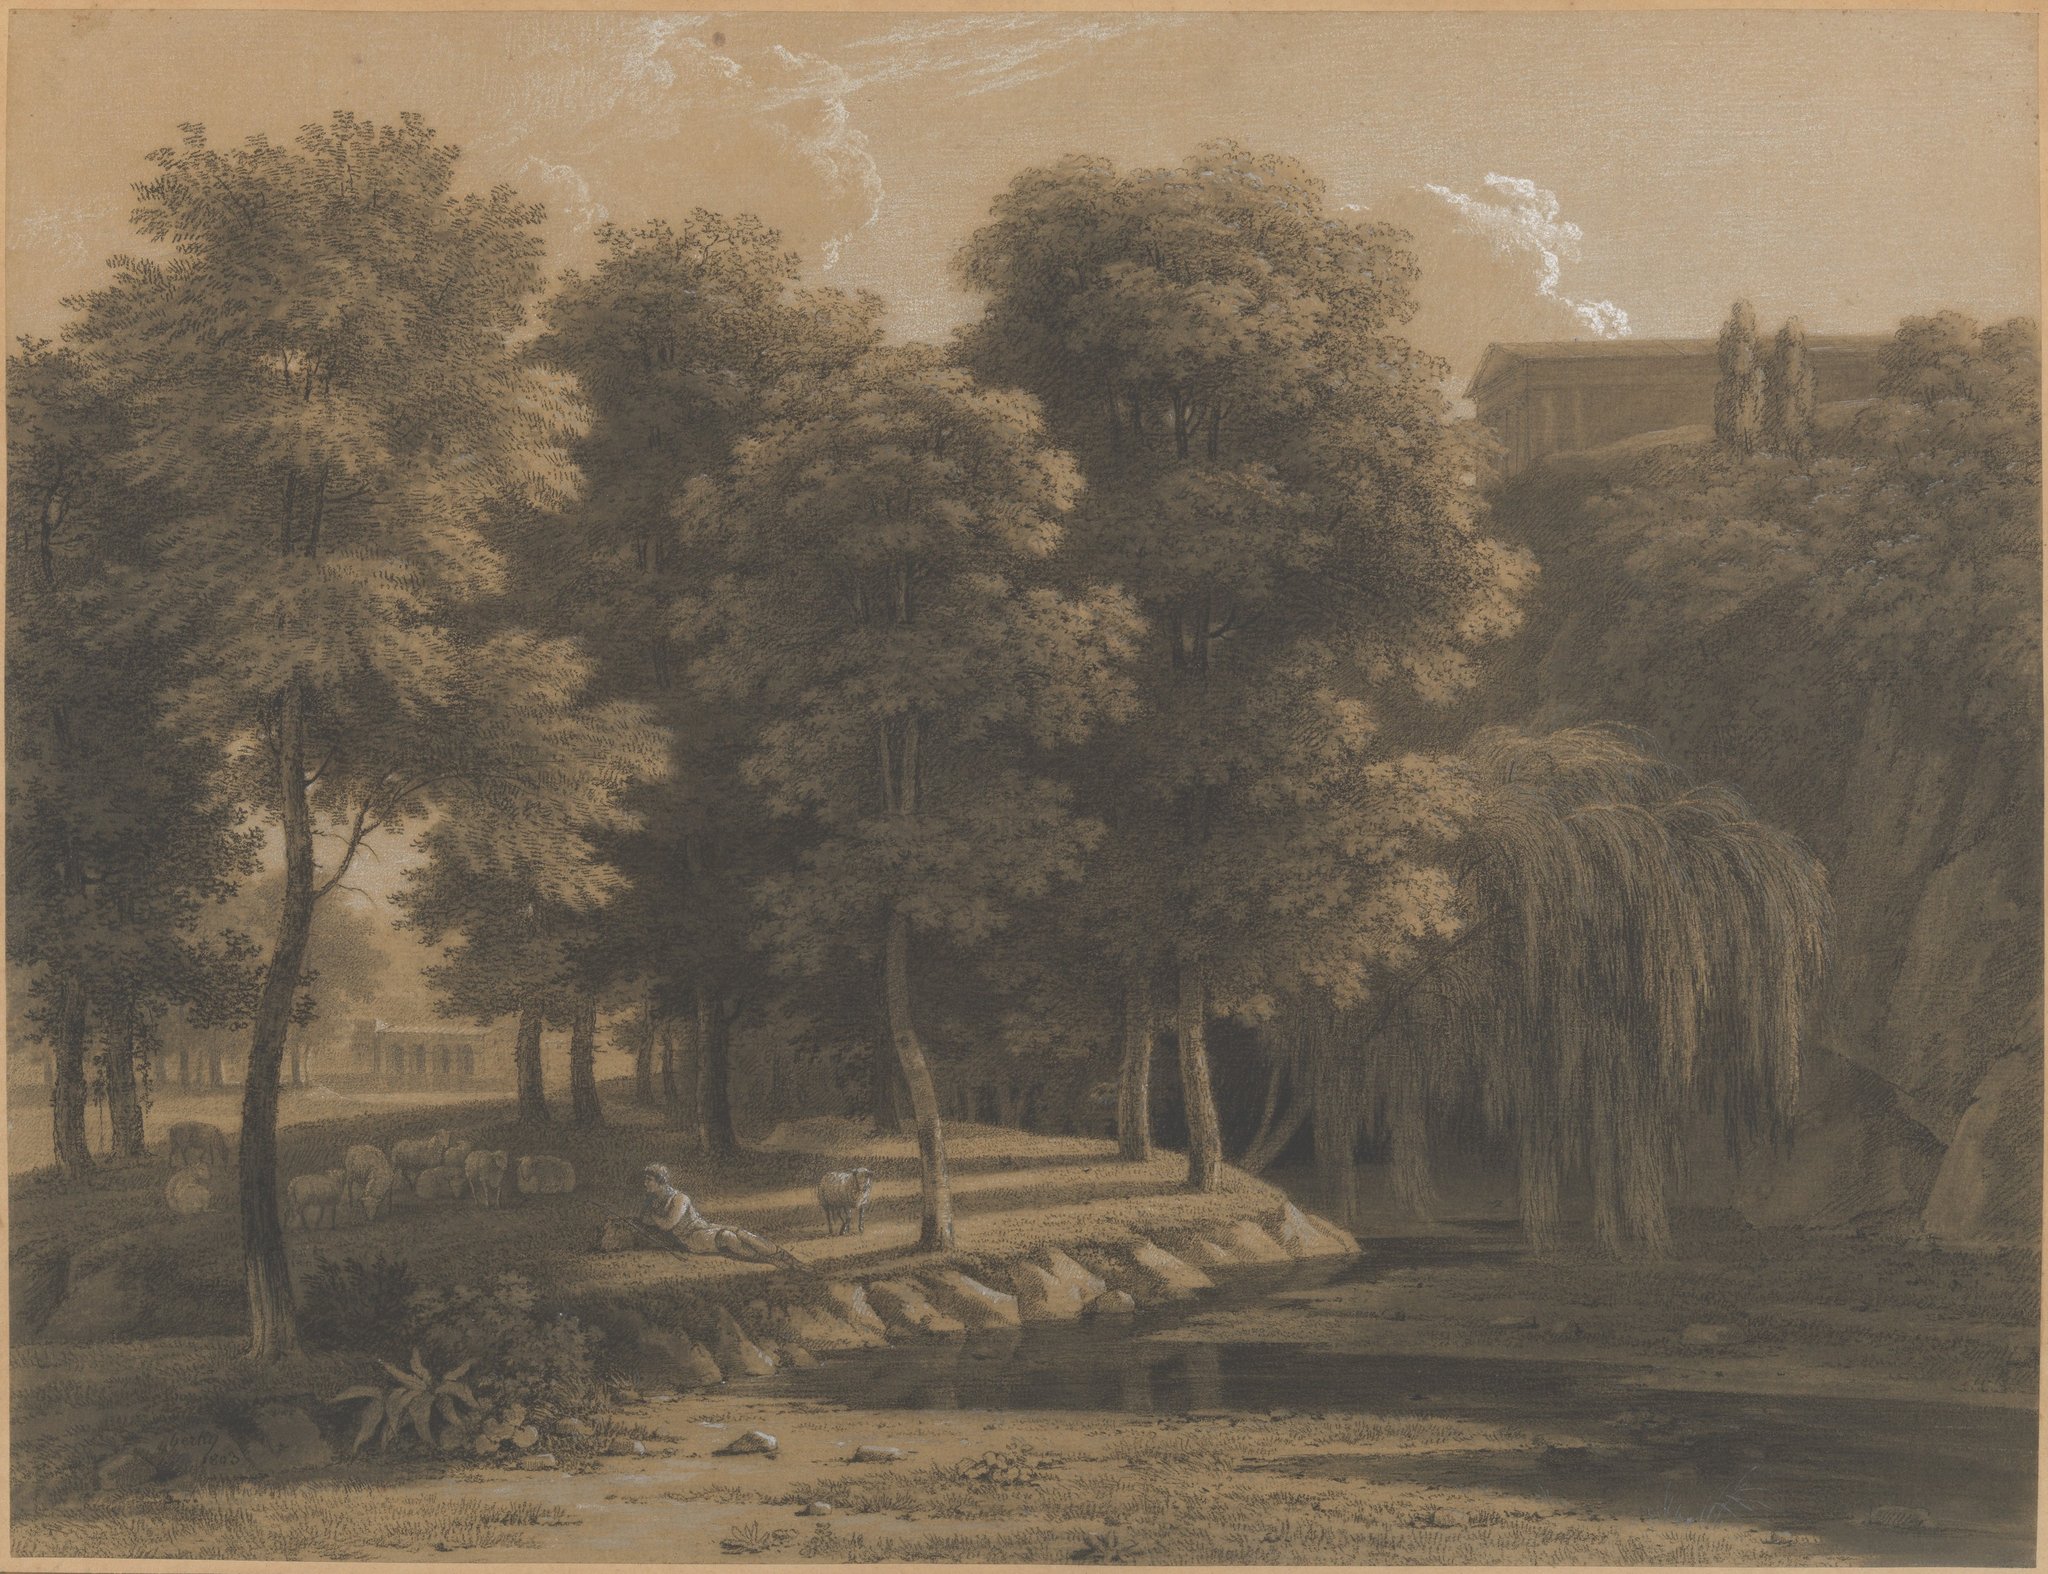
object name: drawing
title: Classical Landscape with a Shepherd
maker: jean victor bertin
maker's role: artist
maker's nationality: french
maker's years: 1767-1842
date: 1803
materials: chalk, gouache, paper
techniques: heightening, wash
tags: sheep,landscapes,trees,shepherds